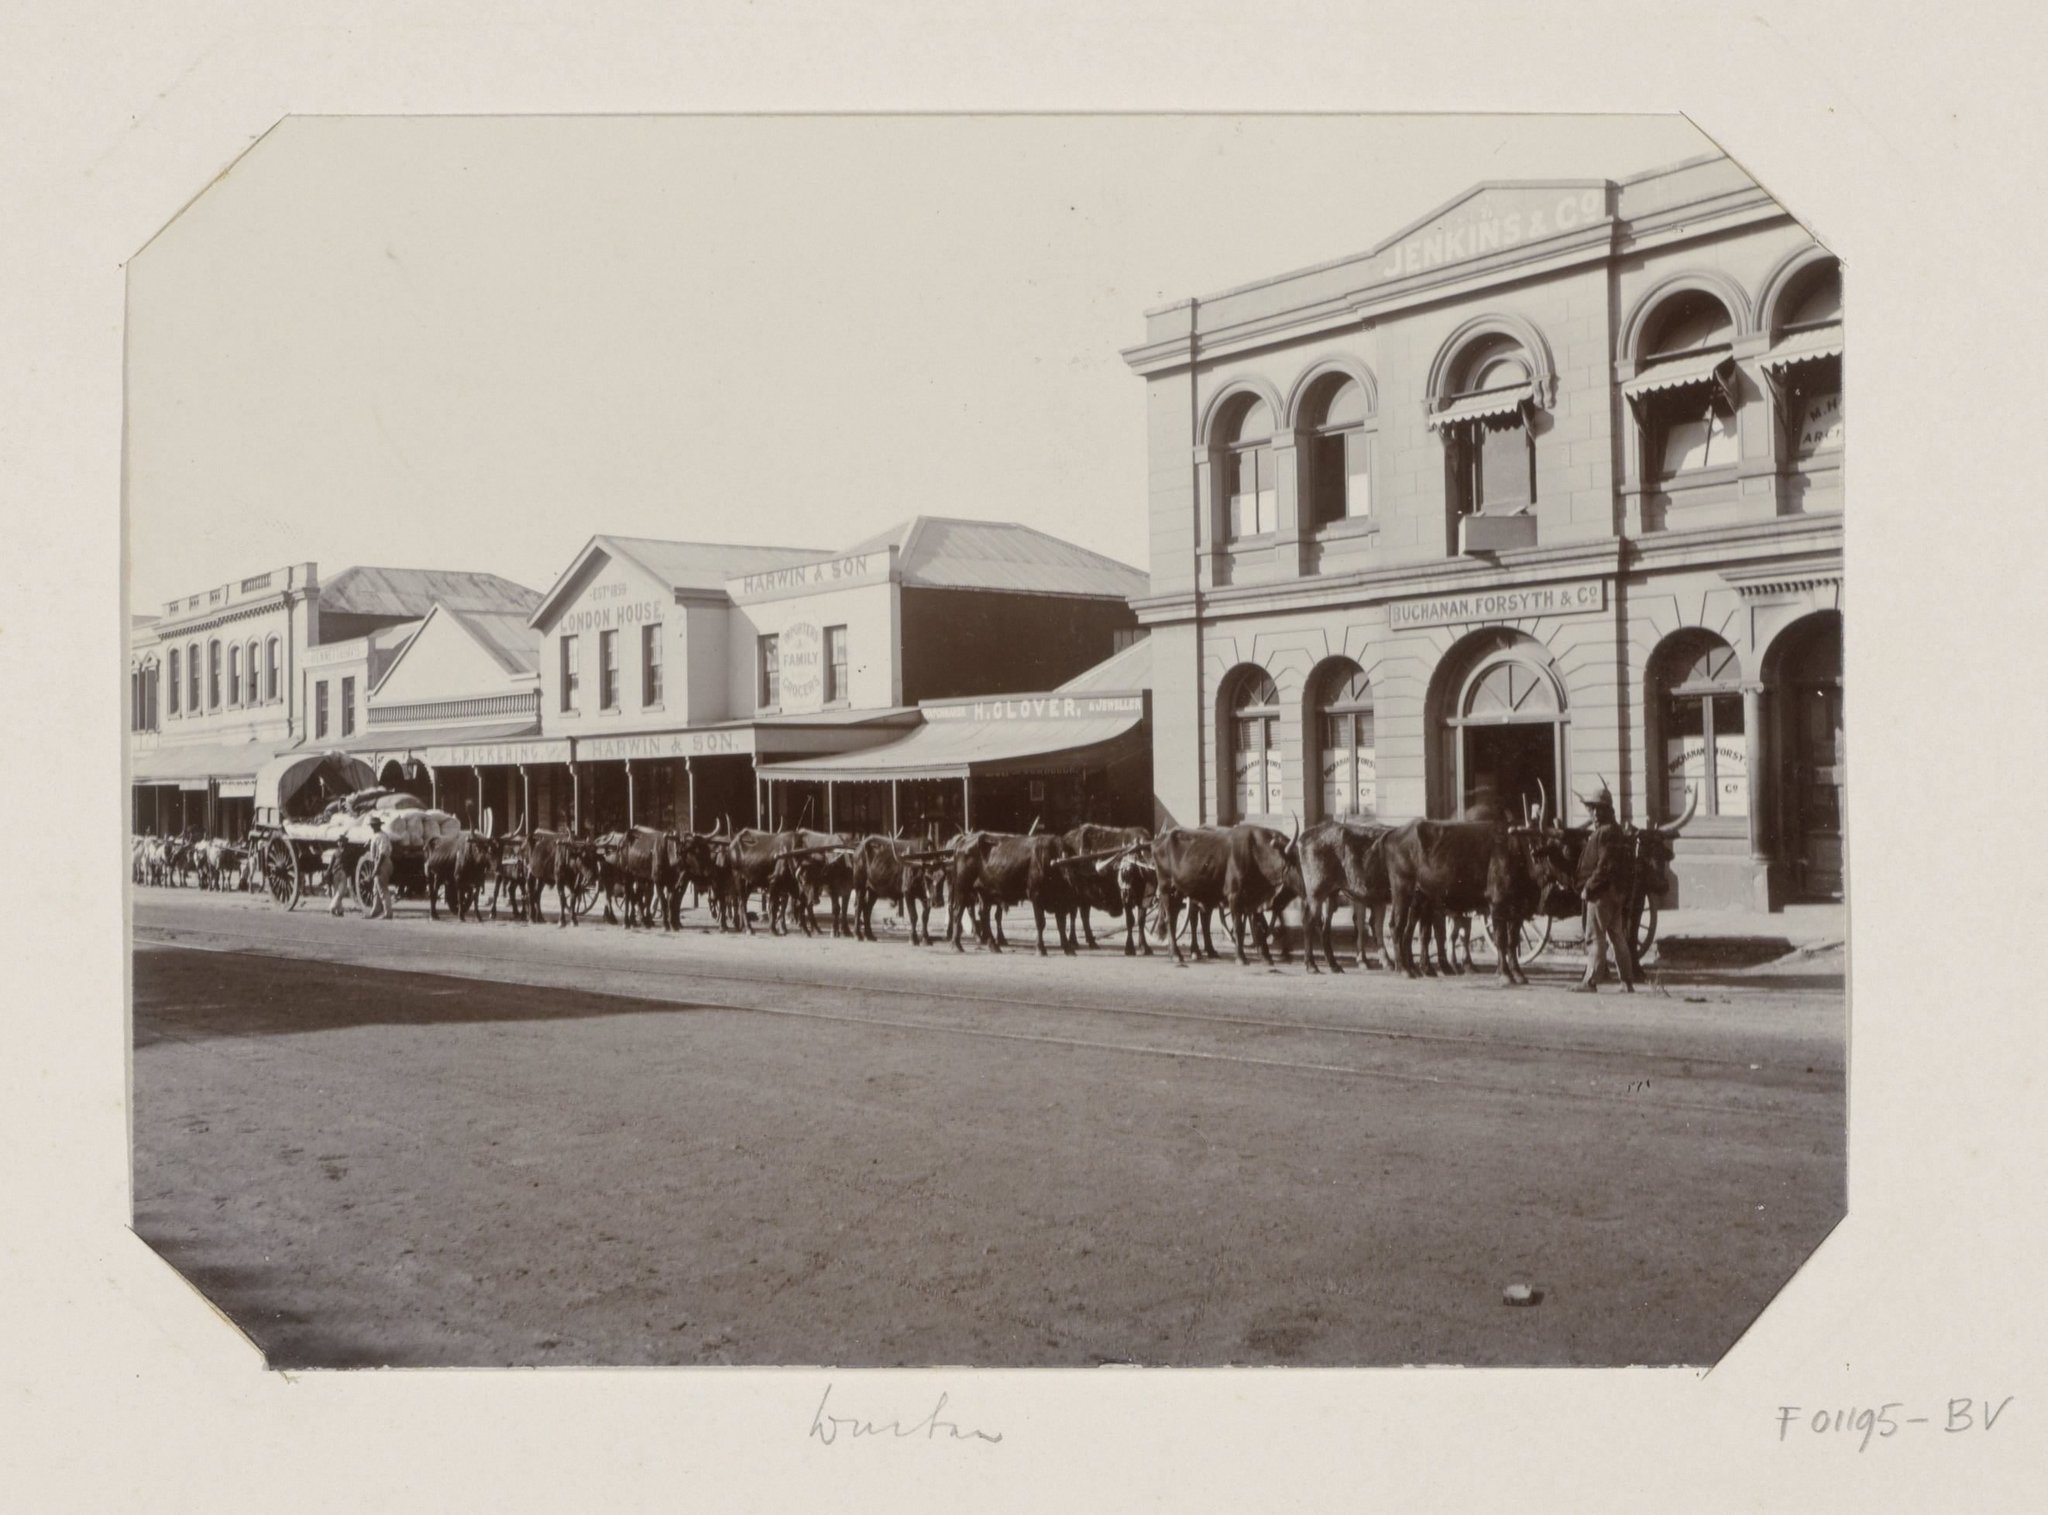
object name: photograph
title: Ossen, ossenwagen en winkels in een straat in Durban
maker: Anonymous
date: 1890-1920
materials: cardboard, paper, photographic support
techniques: gelatin silver print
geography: durban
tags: animal traction, animal-drawn vehicle (carriage etc.)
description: Onderdeel van Fotoalbum van een reis door de Verenigde Staten, Honolulu, Nederlands-Indië, Aden, Zanzibar en Zuidelijk Afrika.